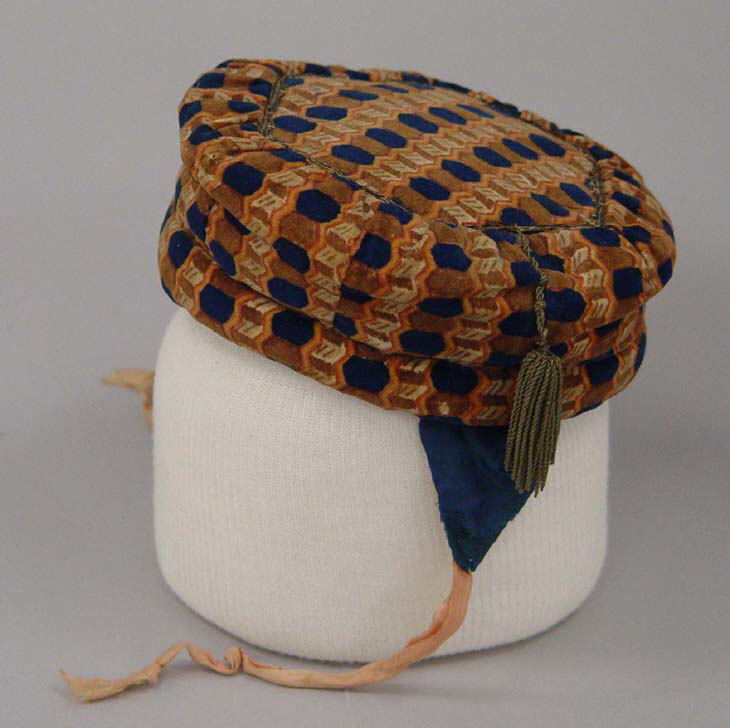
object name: cap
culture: american or european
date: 1860-1879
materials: cotton, silk